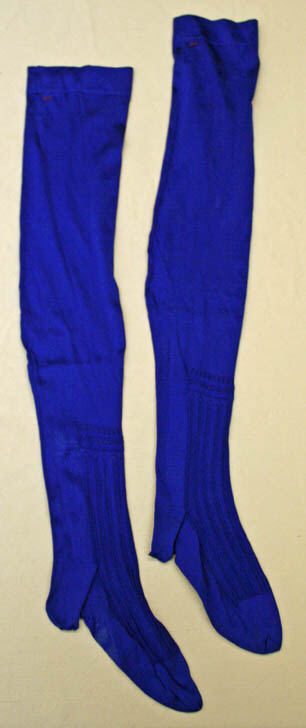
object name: stocking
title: Stockings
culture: french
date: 1900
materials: silk